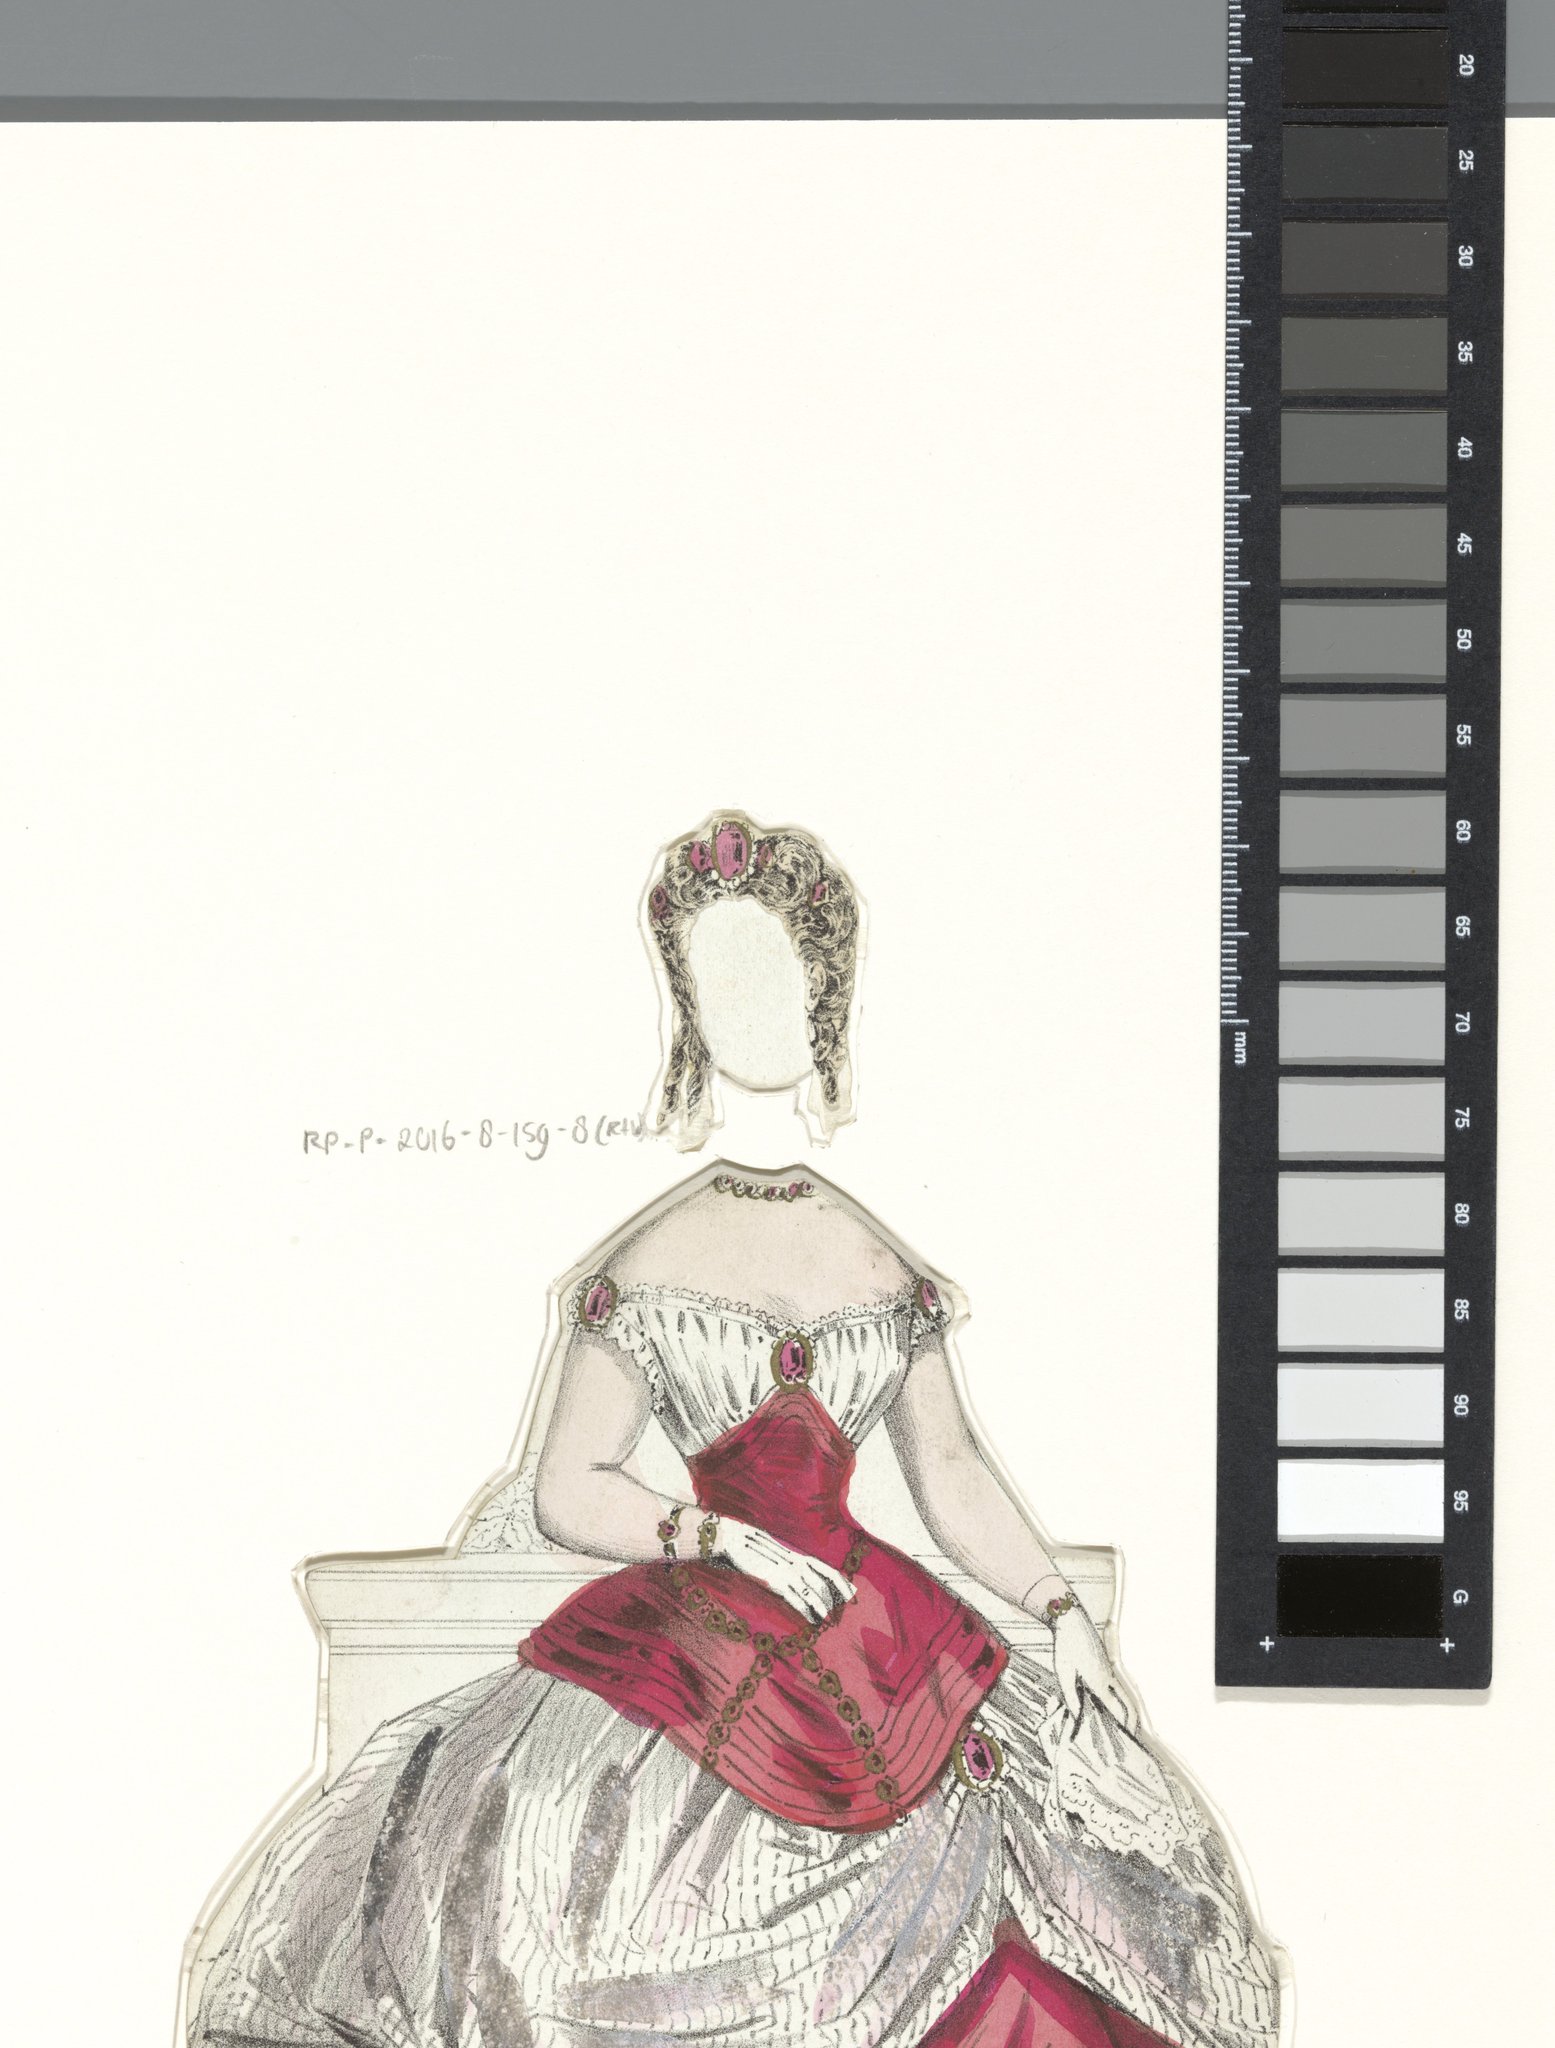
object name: fashion print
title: Kapsel voor een uitknippop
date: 1825-1875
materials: paper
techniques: engraving, hand coloring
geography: paris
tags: fashion plates